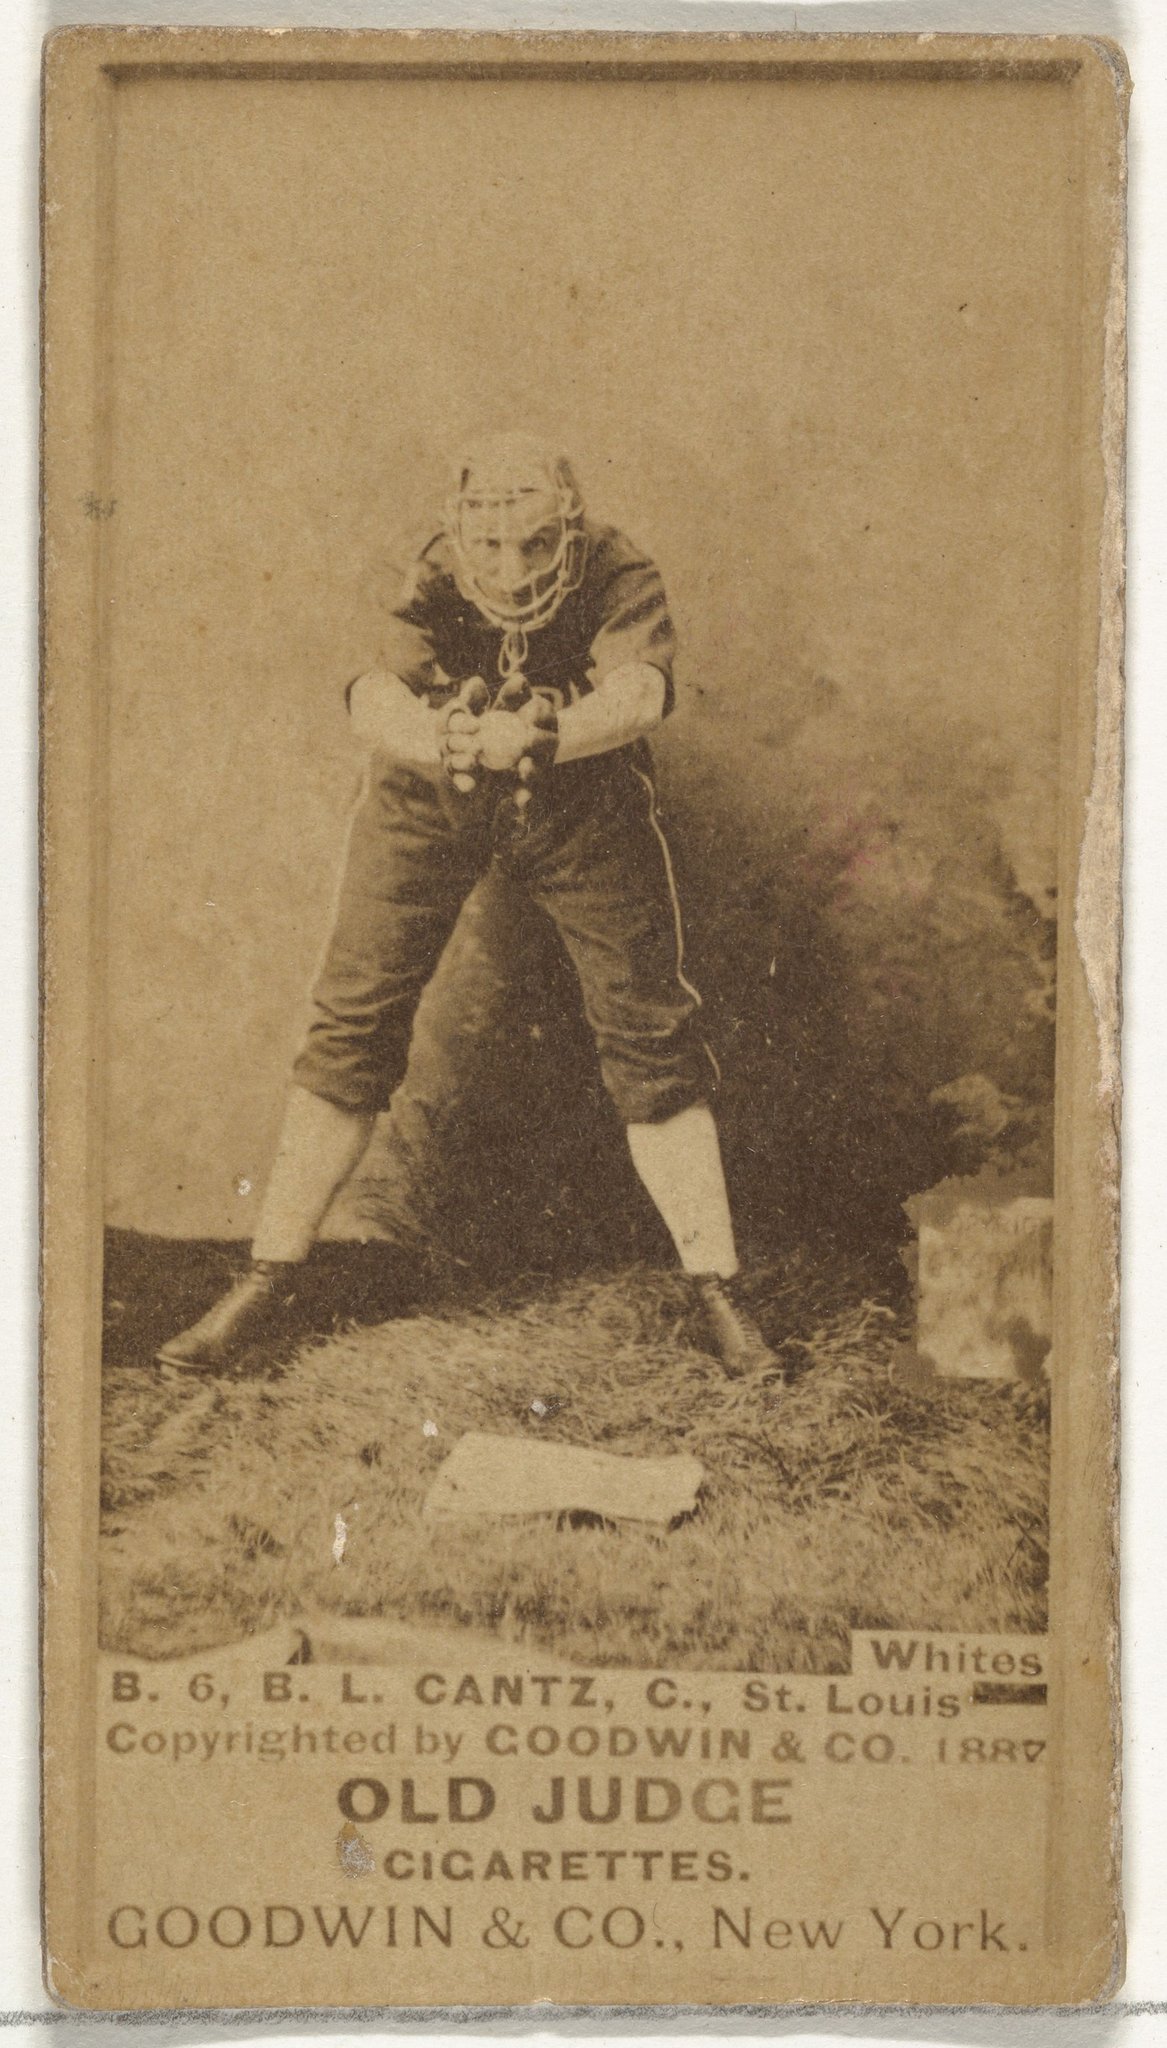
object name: baseball card, photograph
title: Bartholomew L. "Bart" Cantz, Catcher, St. Louis Whites, from the Old Judge series (N172) for Old Judge Cigarettes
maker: goodwin & company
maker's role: publisher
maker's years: 1850-1950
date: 1887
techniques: albumen silver print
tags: men,portraits,baseball,athletes